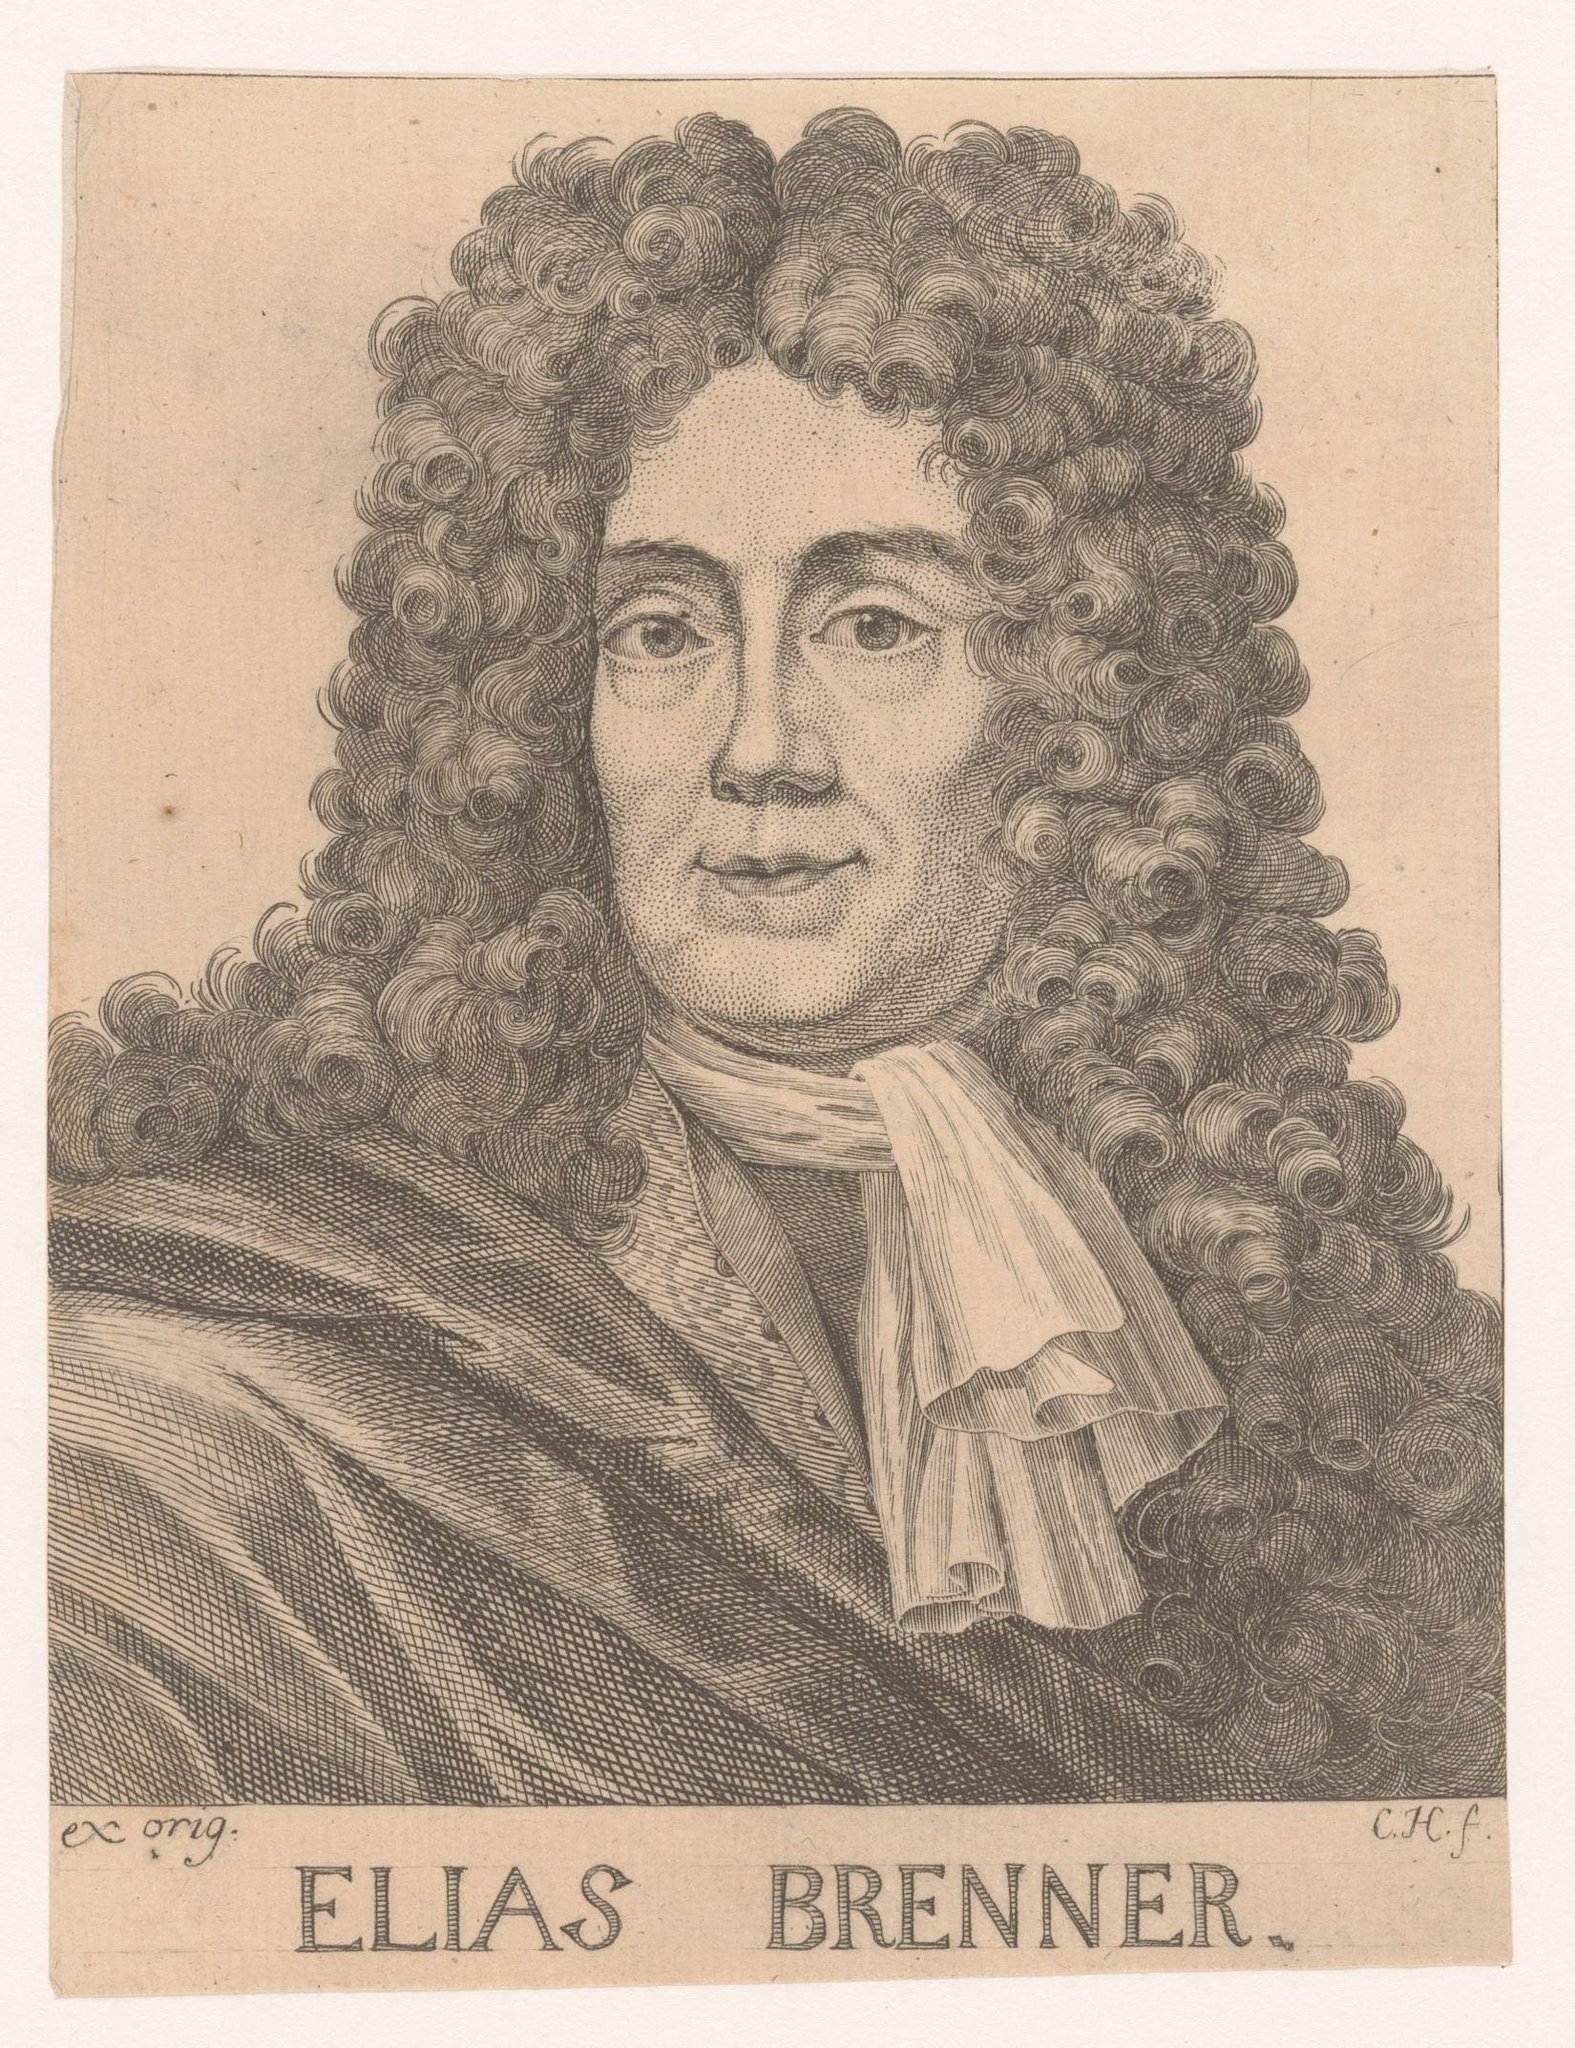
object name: print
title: Portret van Elias Brenner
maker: monogrammist ch (18e eeuw)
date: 1700-1799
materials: paper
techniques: engraving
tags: print maker, historical persons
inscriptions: collector's mark: Lugt 2228